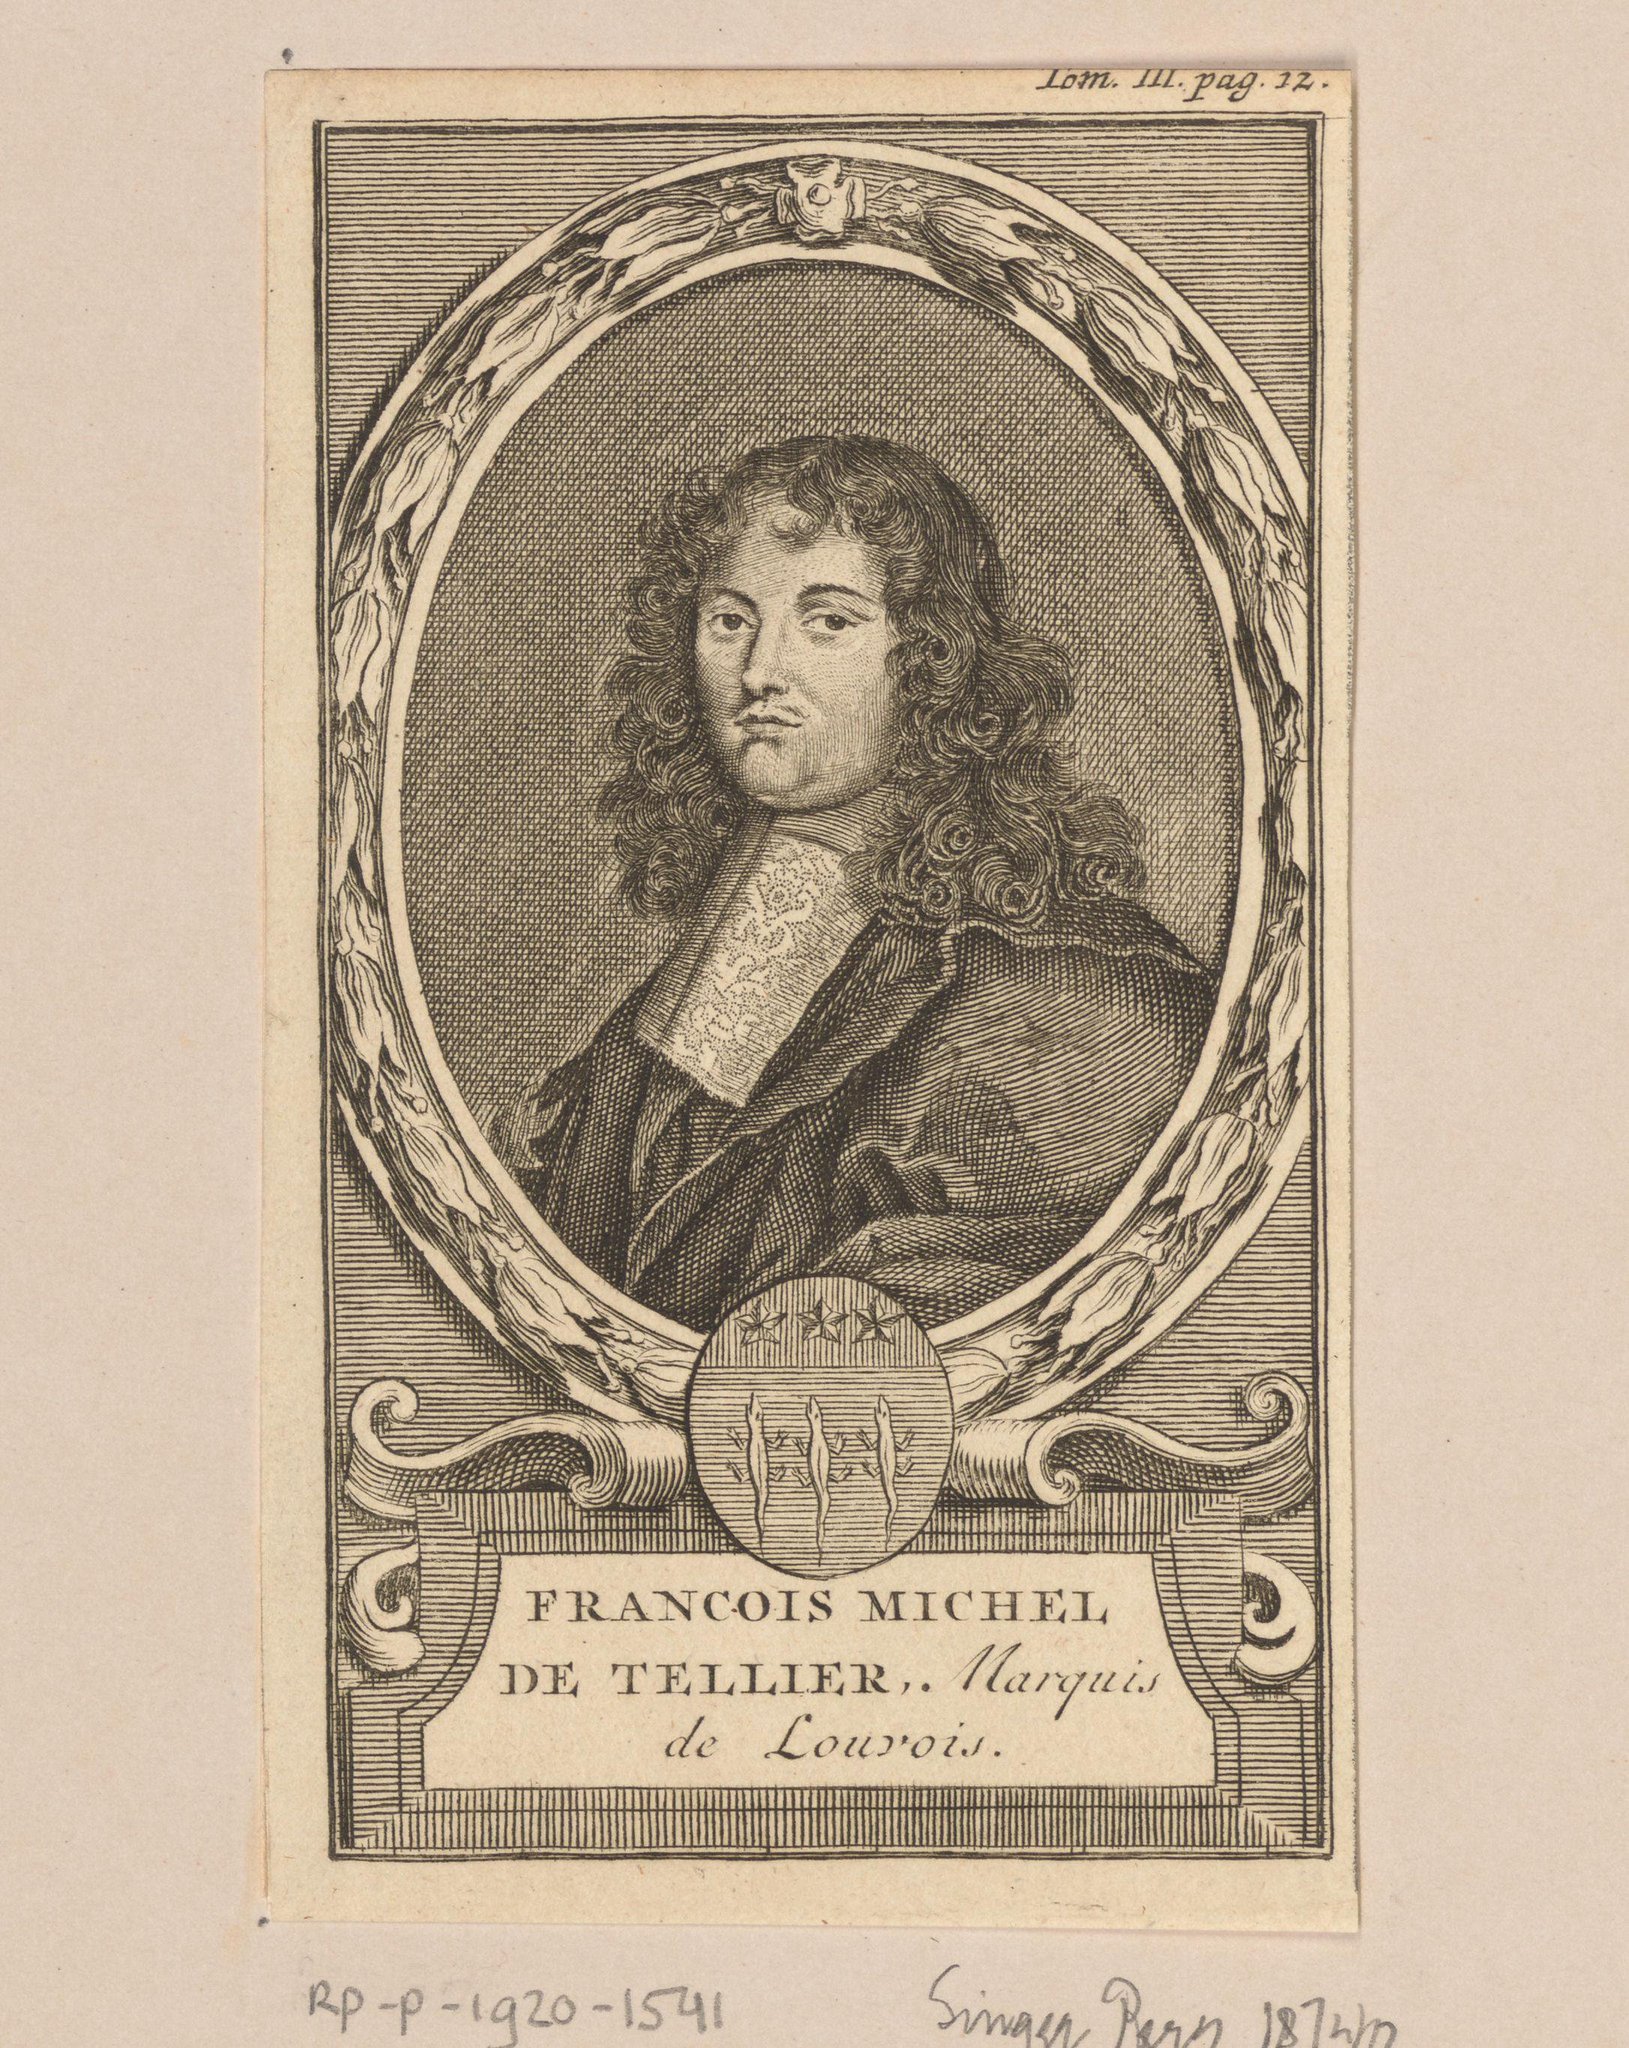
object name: book illustration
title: Portret van François-Michel le Tellier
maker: Anonymous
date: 1680-1730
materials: paper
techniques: engraving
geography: france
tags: paris, françois-michel le tellier (markies de louvois), ornament ~ medallion, historical persons, armorial bearing, heraldry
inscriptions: collector's mark: Lugt 2228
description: Prent komt uit een onbekende publicatie.